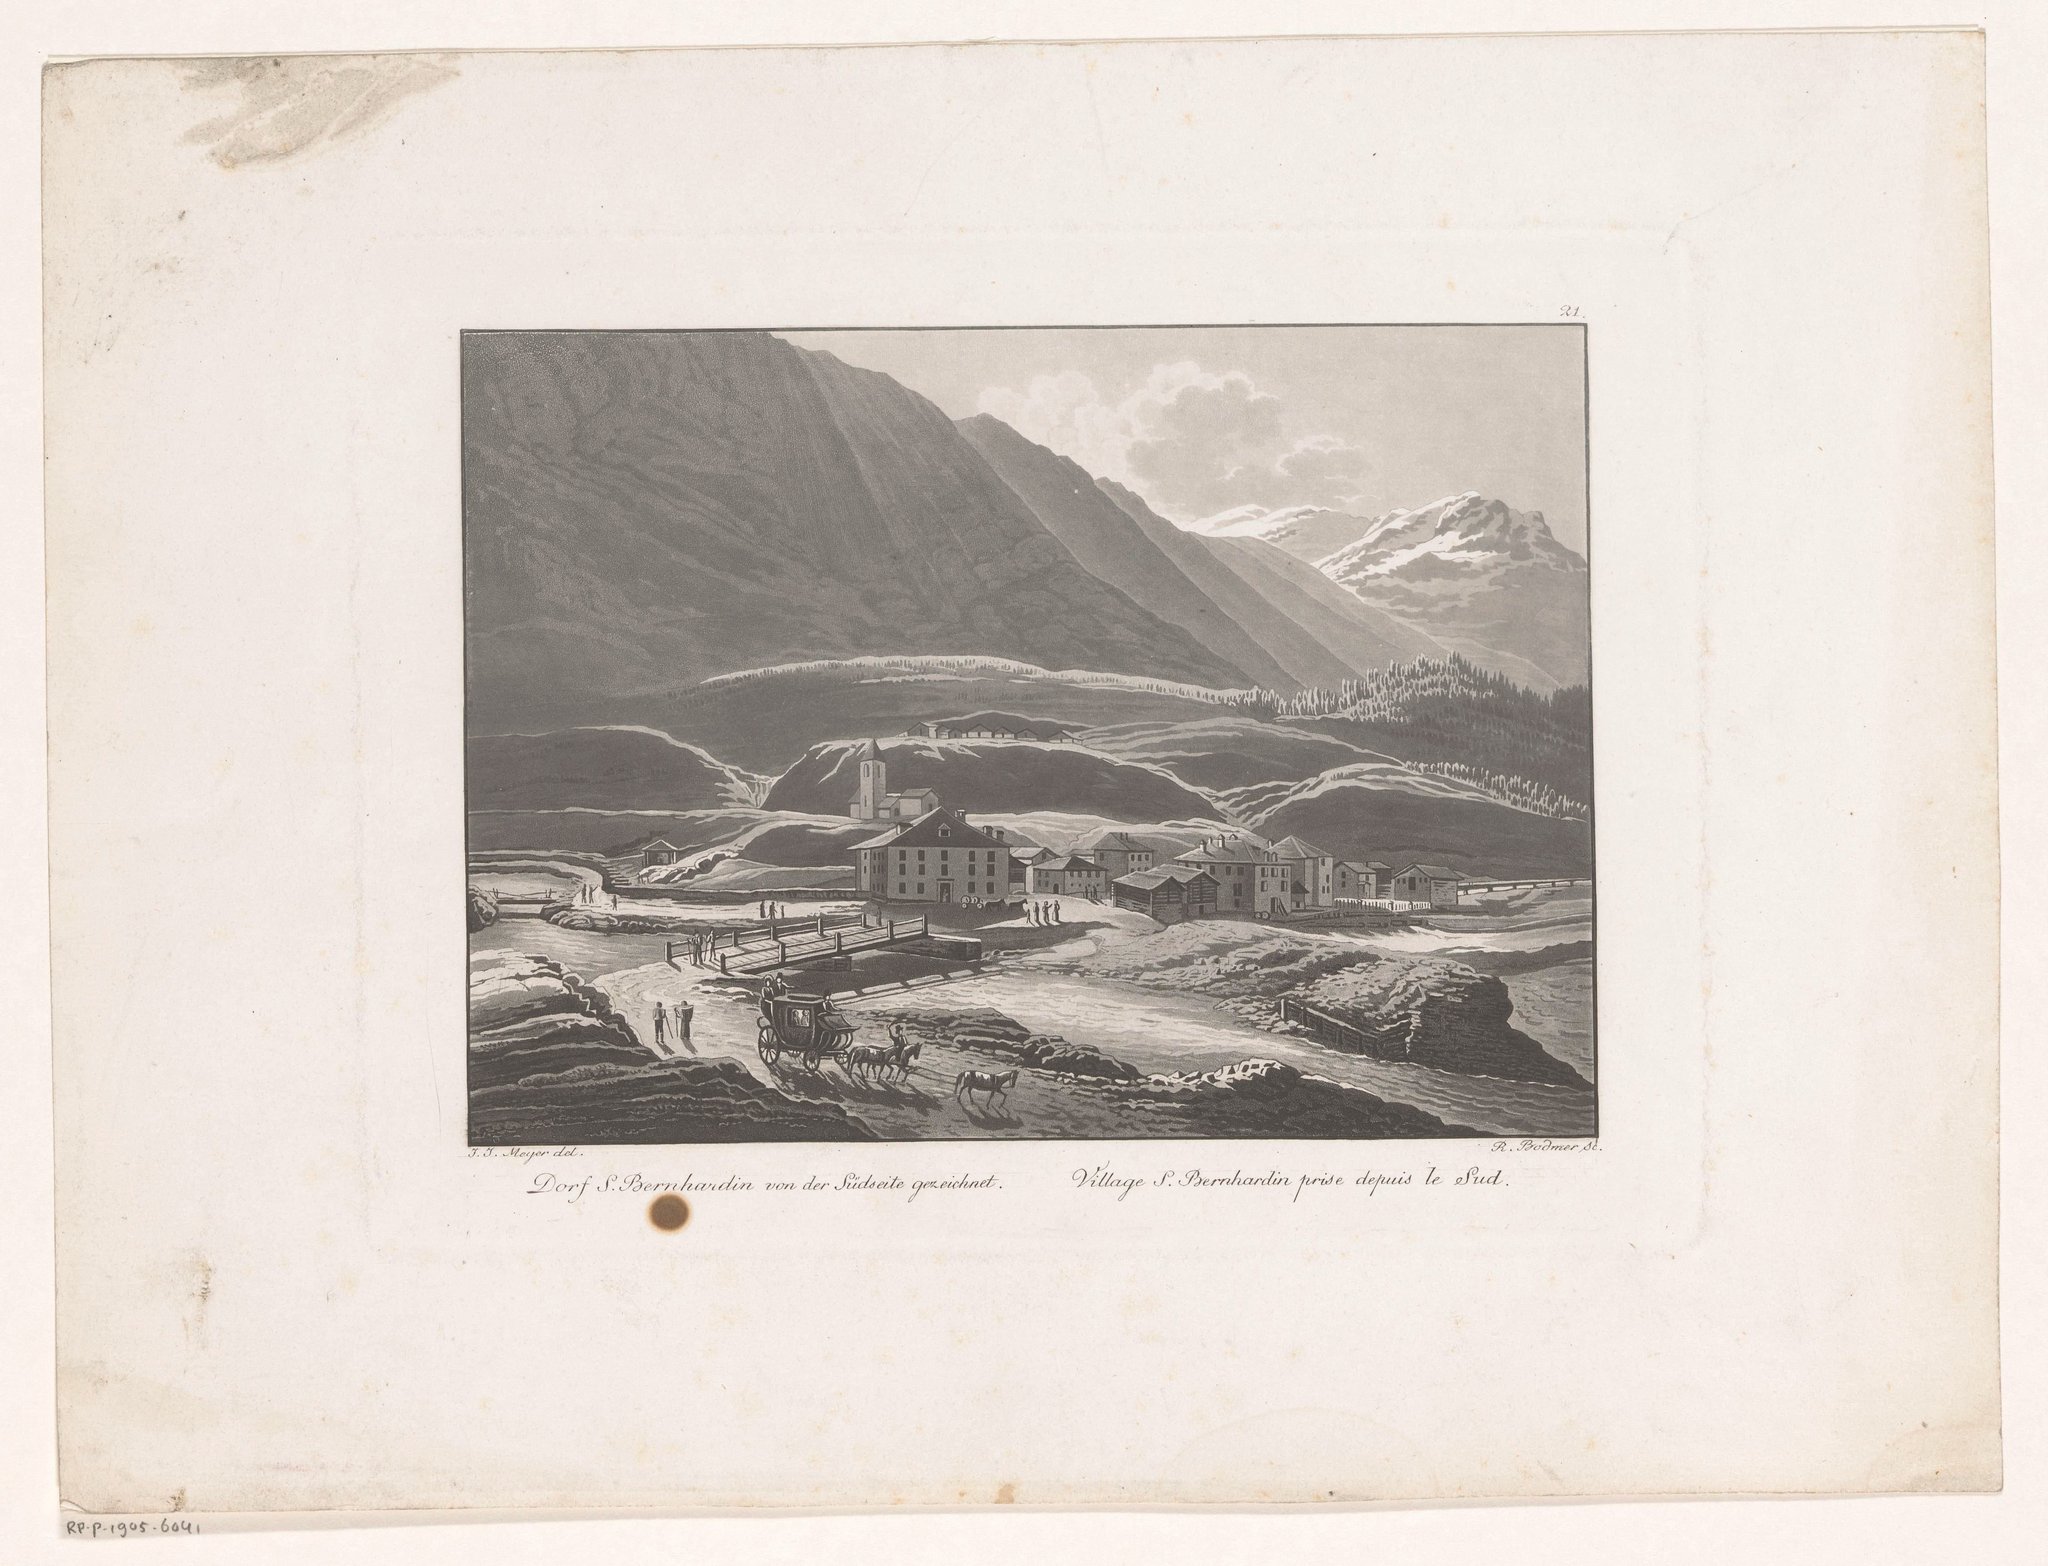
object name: print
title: Dorf S. Bernhardin von der Südseite gezeichnet / Village S. Bernhardin prise depuis le Sud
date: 1826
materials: paper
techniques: aquatint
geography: zurich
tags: prospect of village, silhouette of village, four-wheeled, animal-drawn vehicle, e.g.: cab, carriage, coach, mountains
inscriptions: collector's mark: Lugt 2228